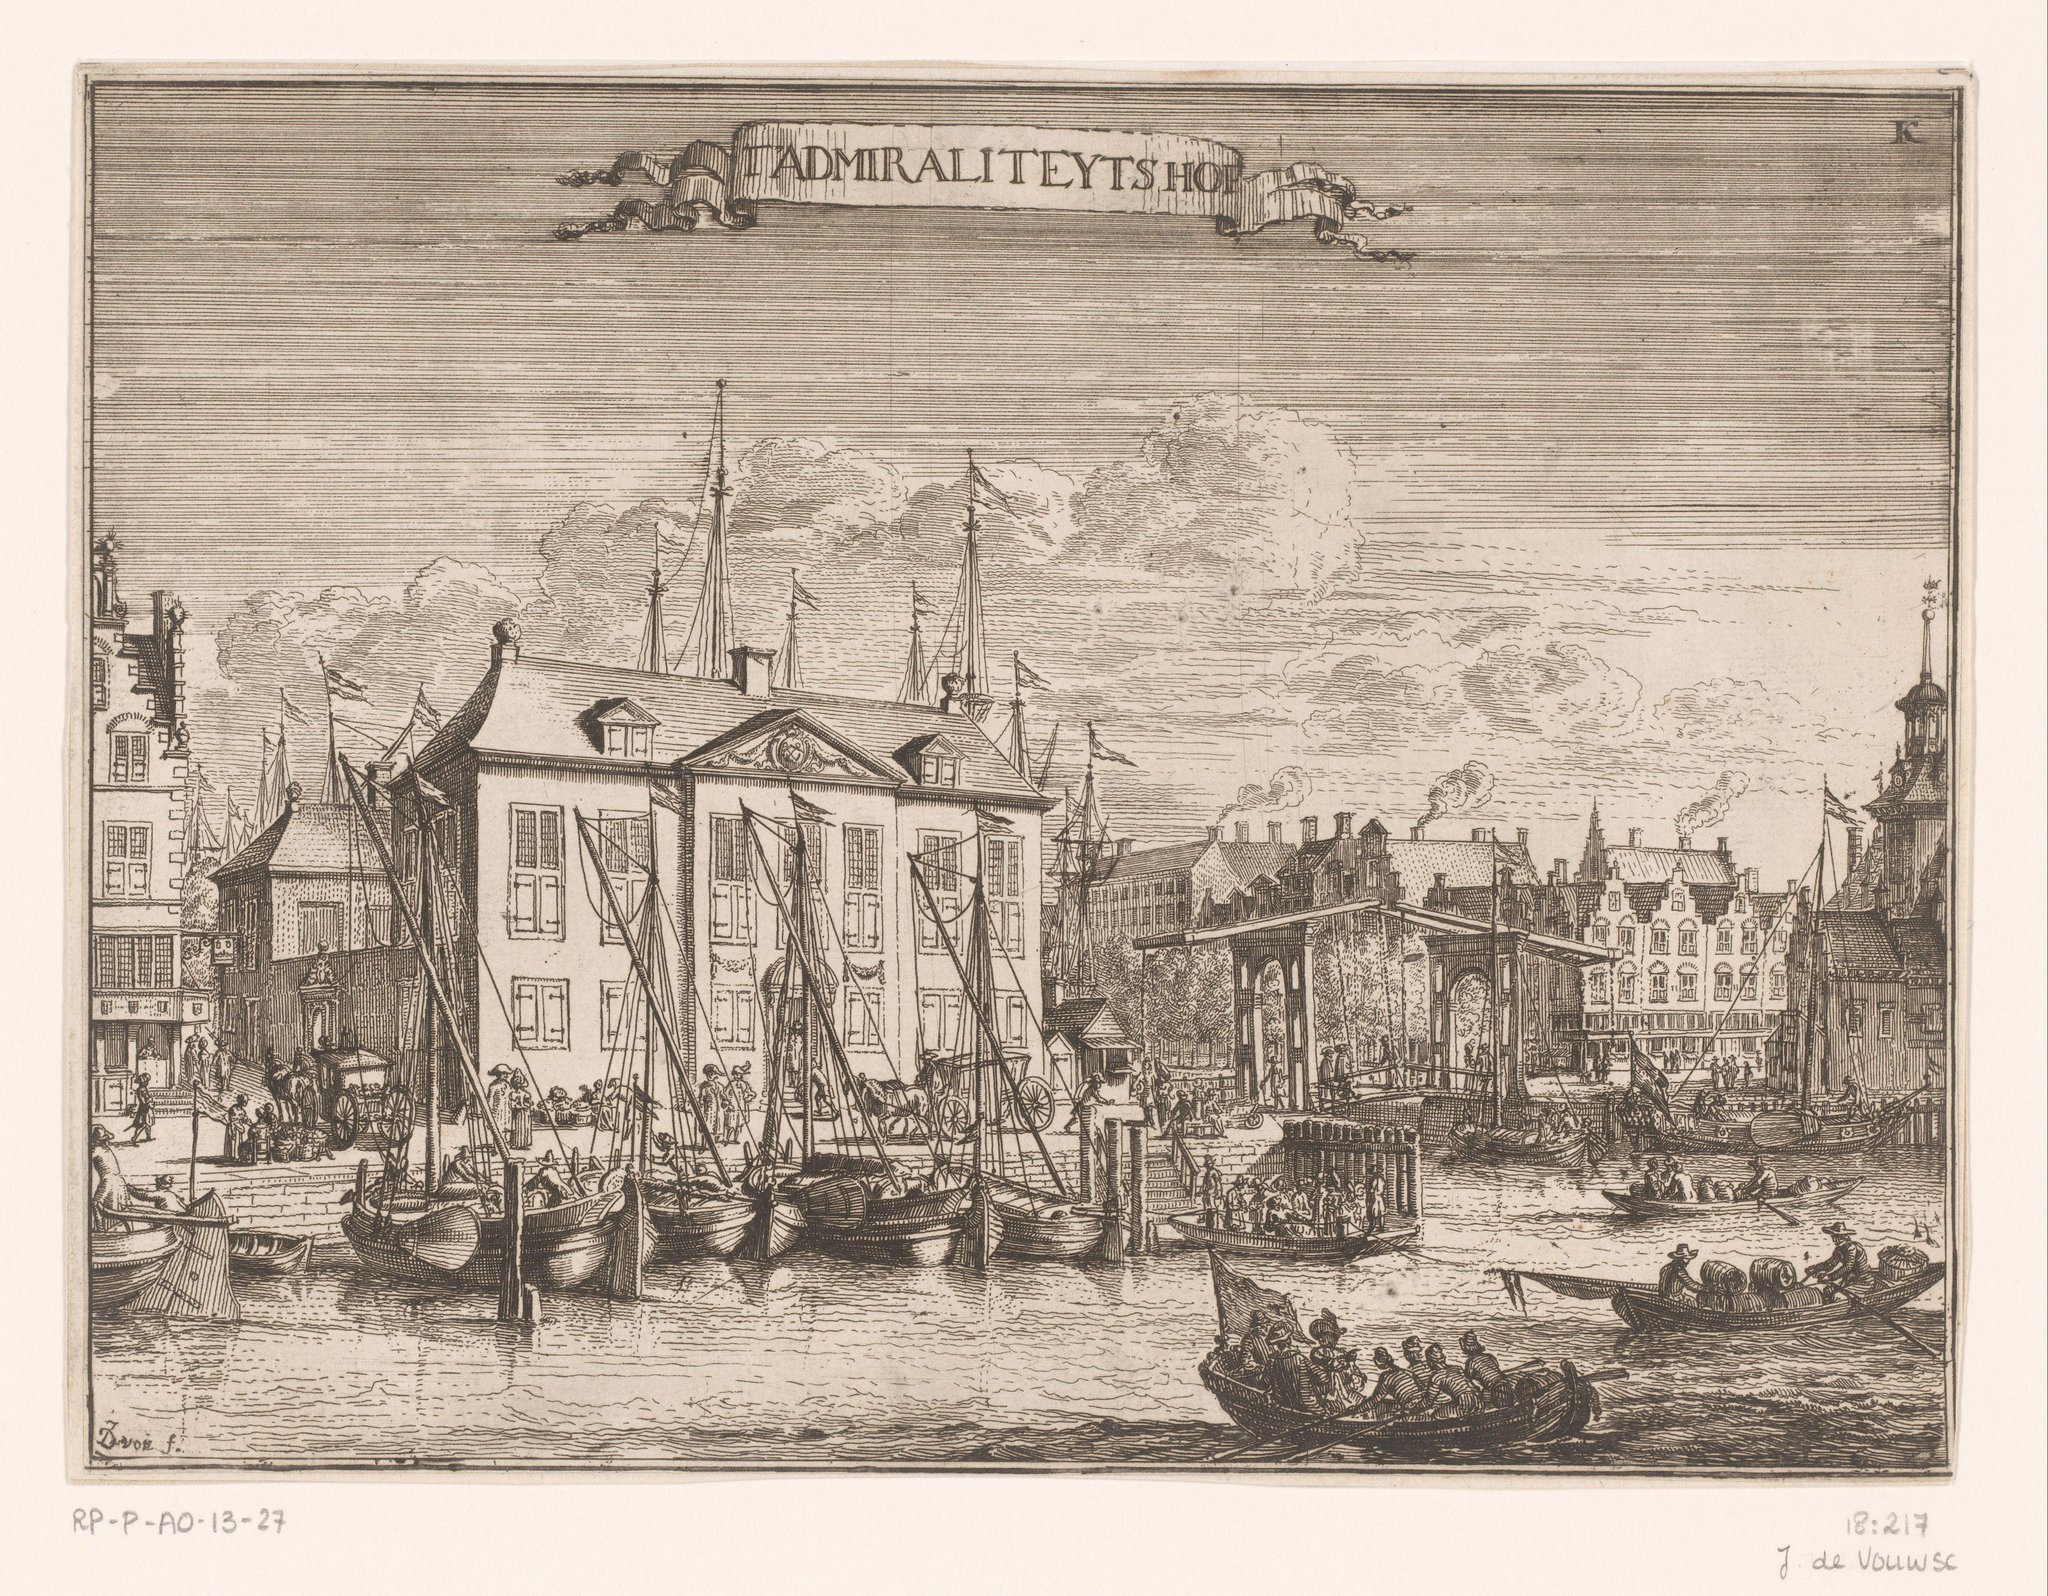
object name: print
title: Gezicht op het Admiraliteitshof te Rotterdam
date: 1694-1695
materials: paper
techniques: etching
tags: exterior ~ representation of a building, bridge in city across river, canal, etc., canals, waters (in city) (+ city(-scape) with figures, staffage)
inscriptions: collector's mark: Lugt 2228, collector's mark: Lugt 195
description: Prent oorspronkelijk gedrukt als onderdeel van de sierrand van 'Rotterdam met al syn gebouwen net op haer maet geteekent en gesneden', een wandkaart van Rotterdam, in prent gebracht door Romeyn de Hooghe en Johannes de Vouw. De rand om de plattegrond bestond uit wapenranden (langs de bovenkant en zijkanten), twaalf stadsgezichten (A-F langs de linker zijkant en G-M langs de rechter zijkant) en een stadsprofiel (langs de onderkant). Zie documentatie voor meer informatie. Zie ook RP-P-AO-13-87.